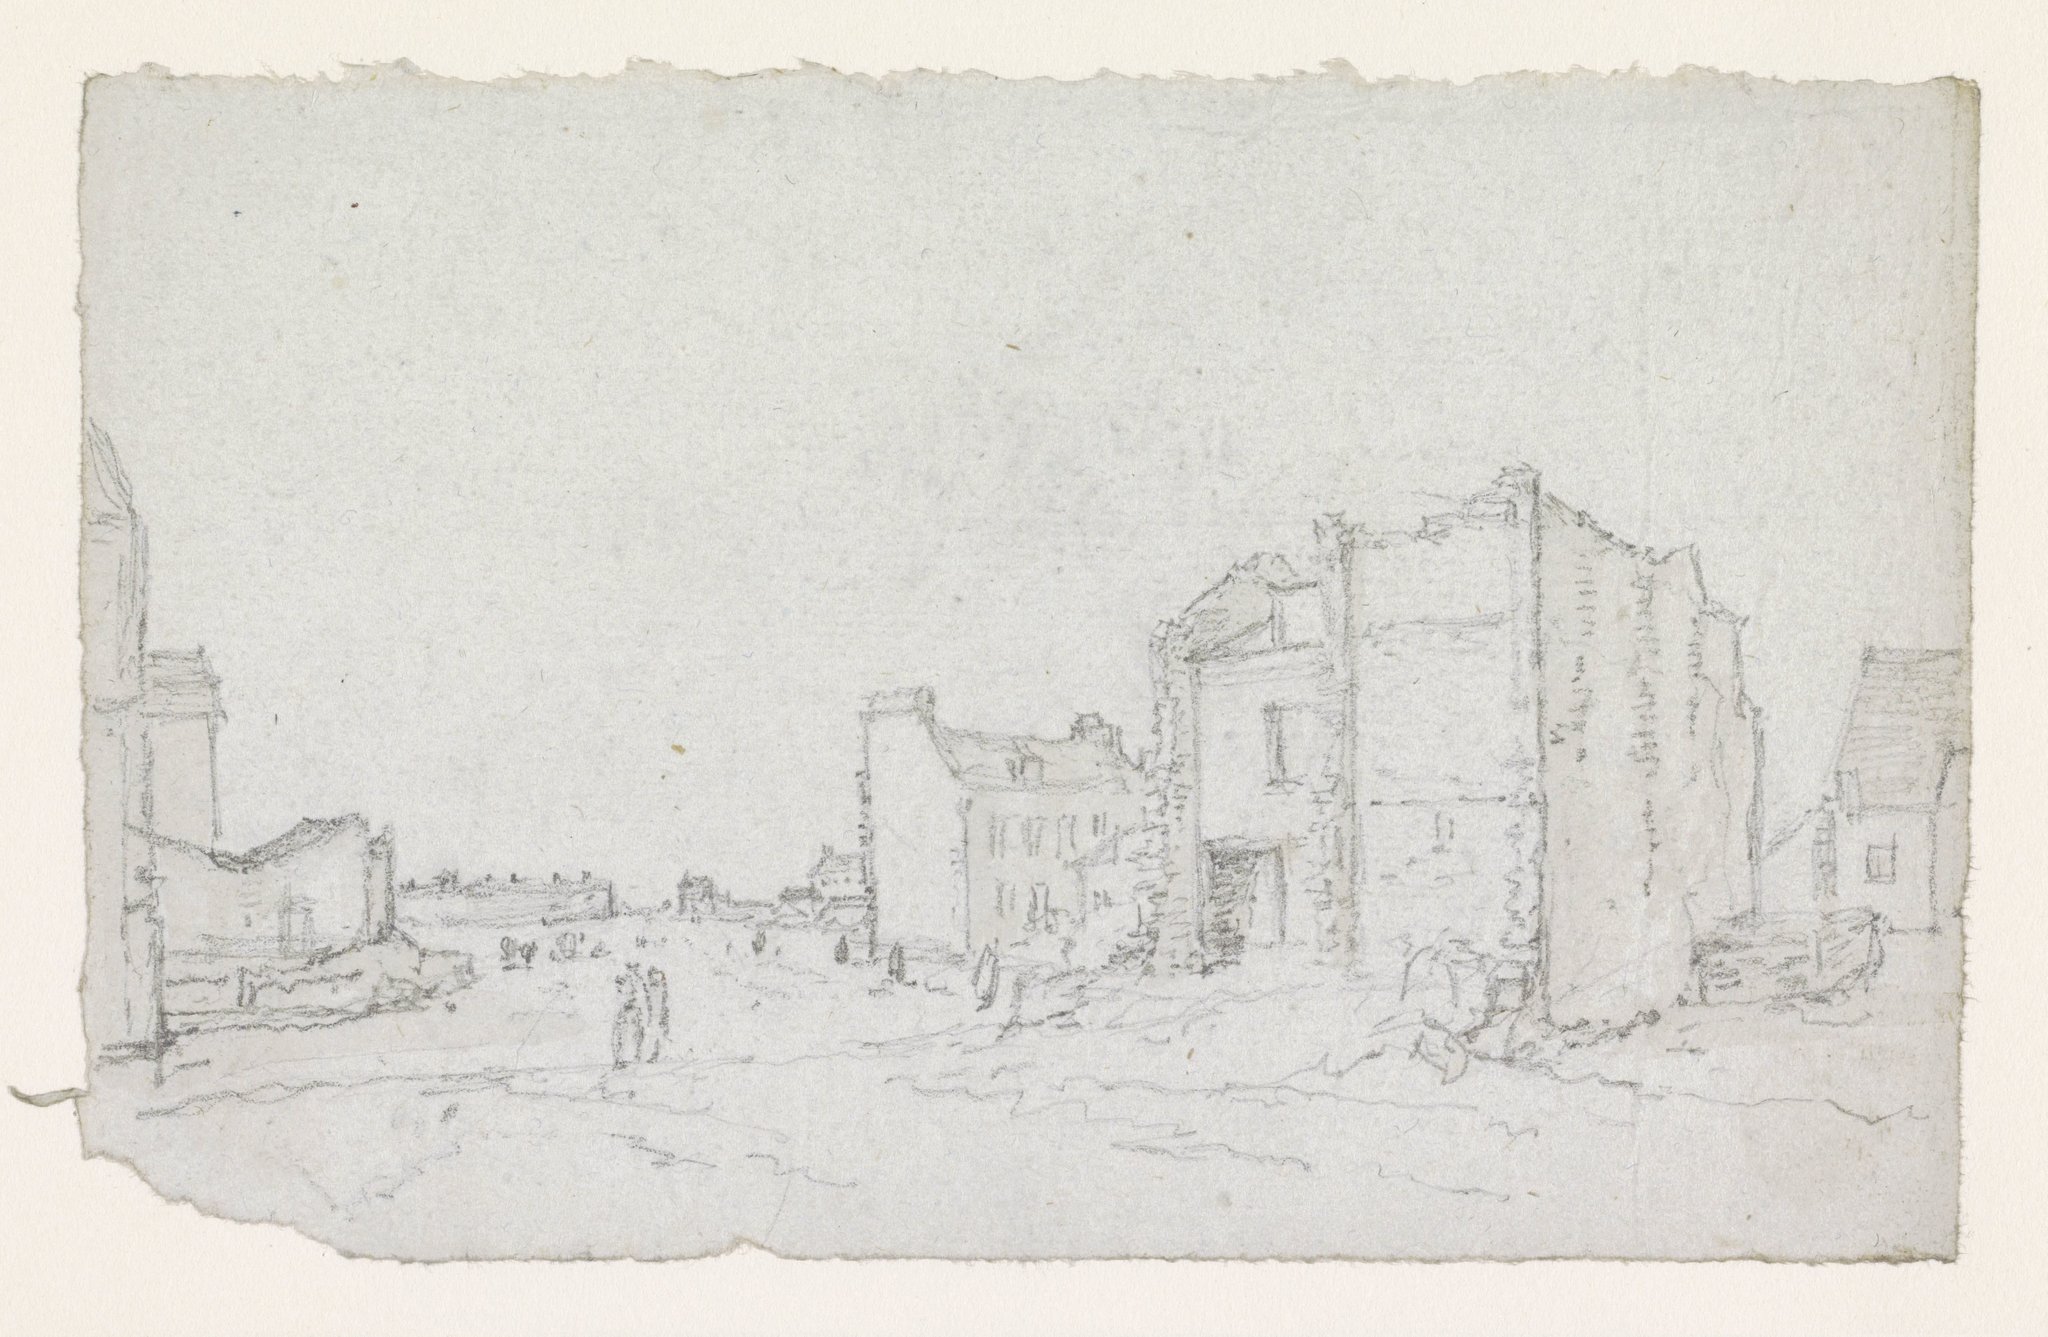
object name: drawing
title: Half afgebroken huizen aan de rand van de stad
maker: georges michel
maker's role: draughtsman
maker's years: 1763-1843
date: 1773-1843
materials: paper, pencil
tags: outskirts of city (+ city (-scape) with figures, staffage), paris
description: Een van 120 tekeningen, afkomstig uit een 19e eeuws album met tekeningen van Georges Michel.